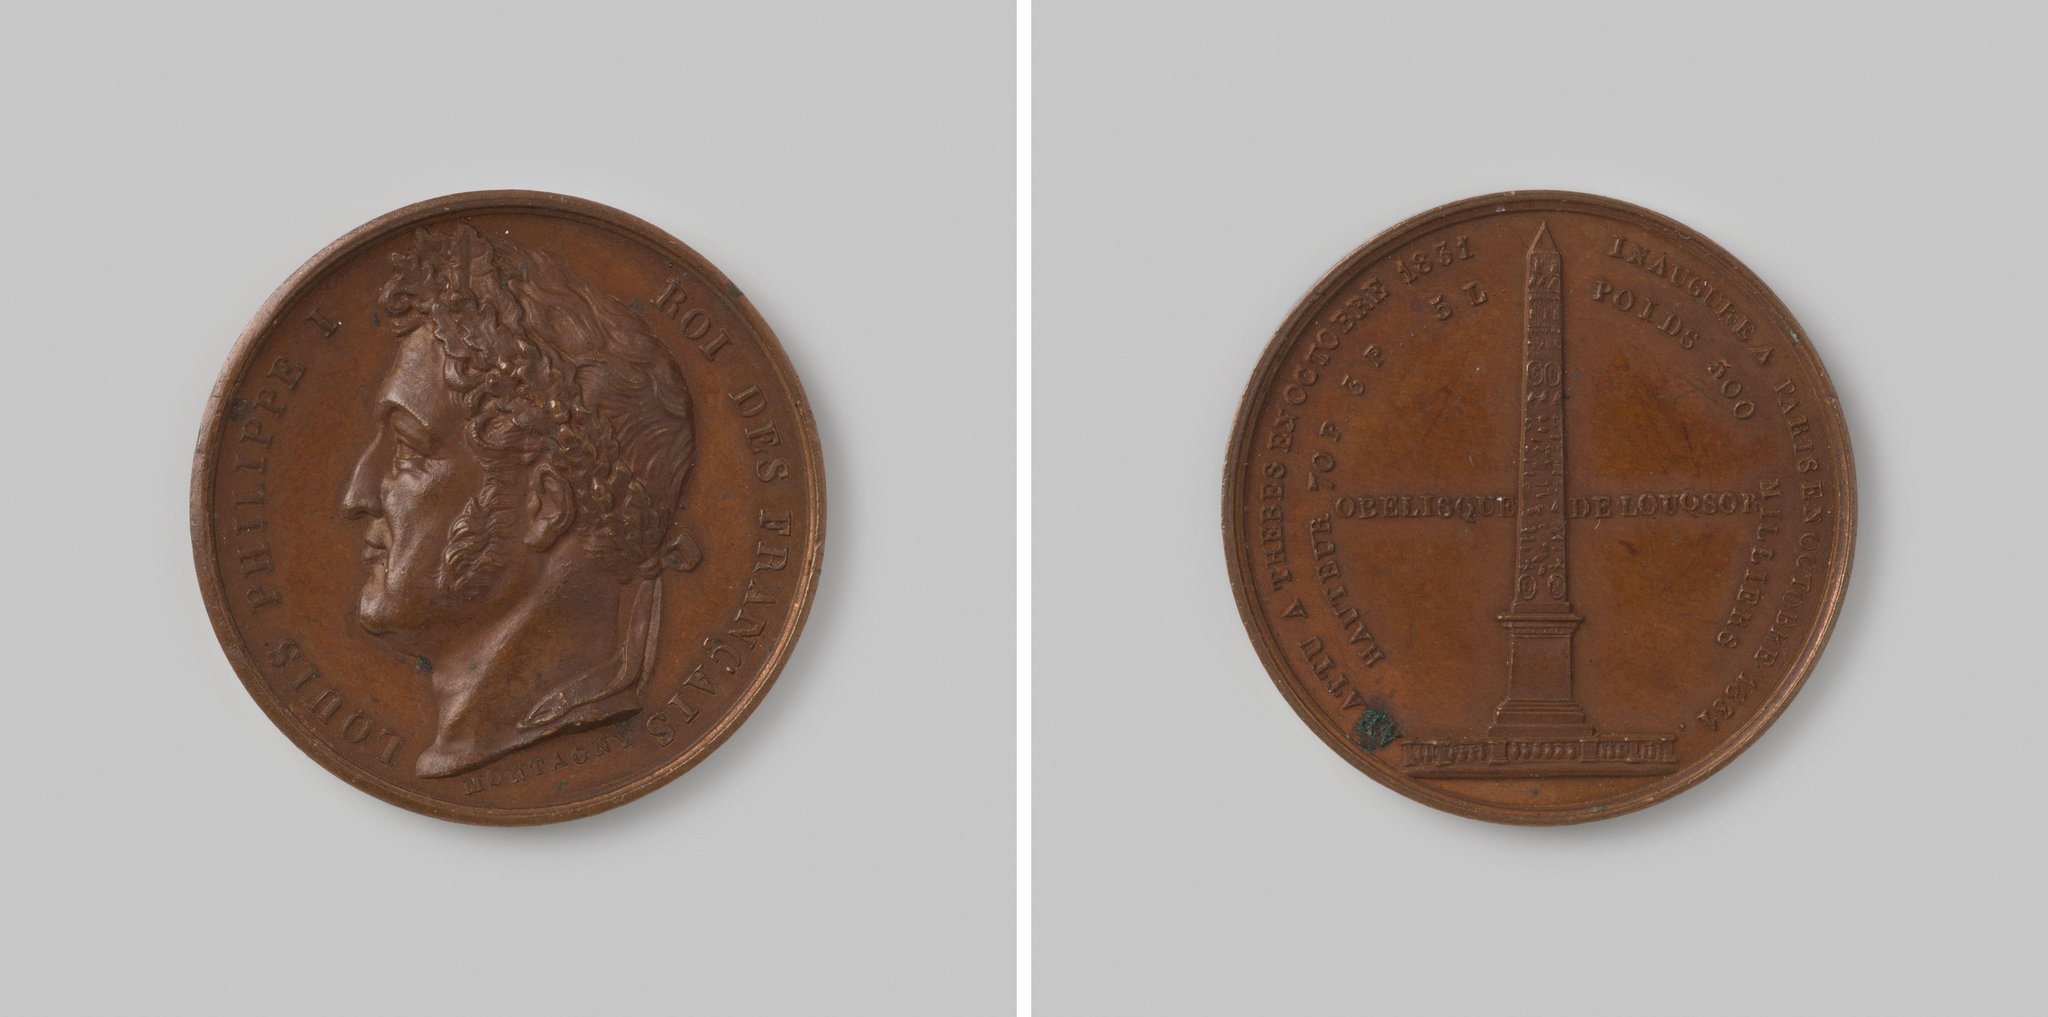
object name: history medal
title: Oprichting van de obelisk van Luxor 1836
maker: jean pierre montagny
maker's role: sculptor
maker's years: 1789-1862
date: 1836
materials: copper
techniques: striking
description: Bronzen penning, op de voorzijde het portret van Koning Louis-Philippe naar links met omschrift, op de keerzijde een obelisk met bijschrift met dubbel omschrift.